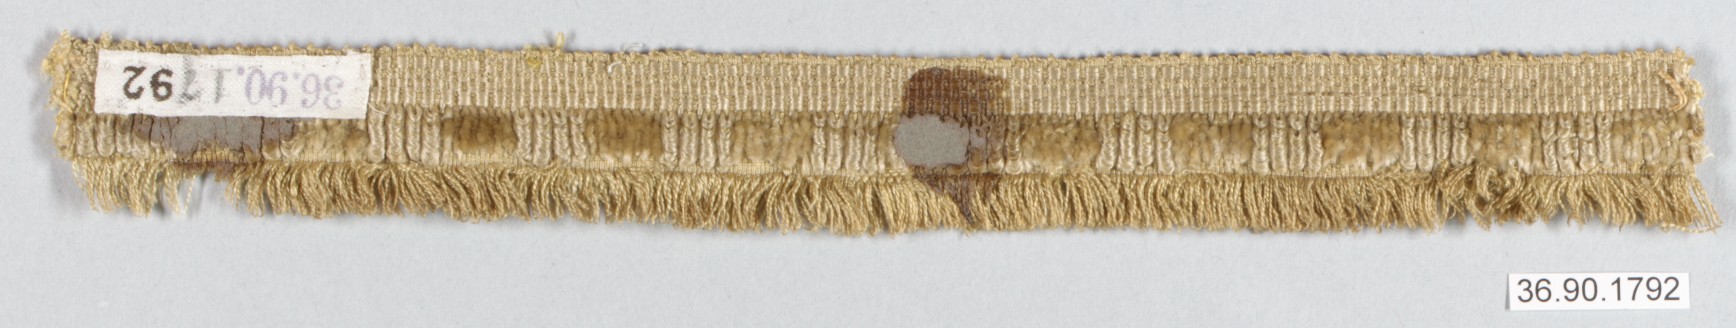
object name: fringe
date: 1734-1766